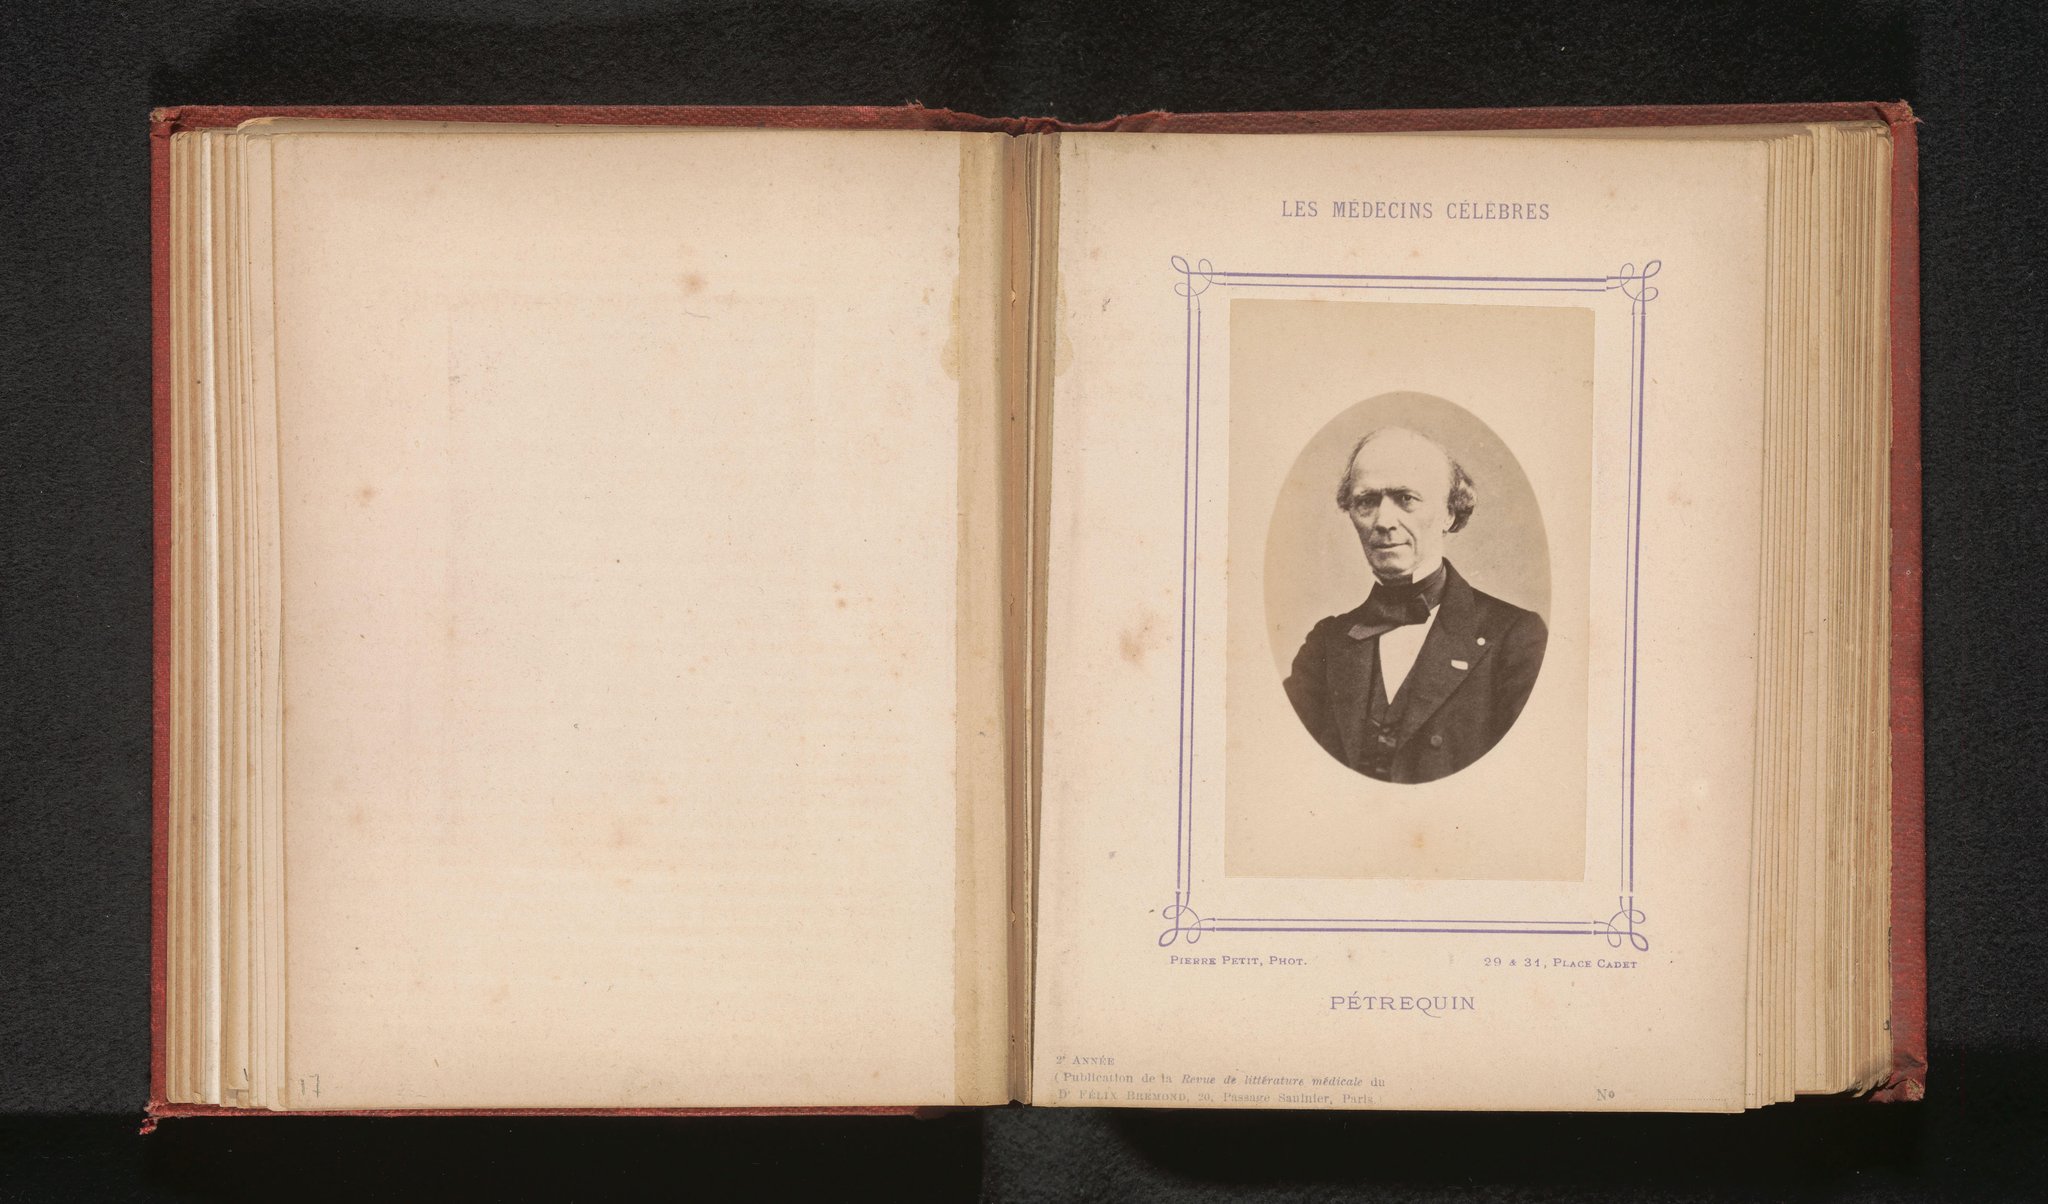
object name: photograph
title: Portret van Joseph-Pierre Pétrequin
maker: pierre petit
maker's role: fotograaf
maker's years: 1832-1909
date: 1871-1879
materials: paper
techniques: albumen print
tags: adult man, historical persons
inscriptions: inscription: ‘(Publication de la Revue de litterature médicale, du/ D. Félix Bremond/ 20, Passage Saulnier, Paris./ No.]’